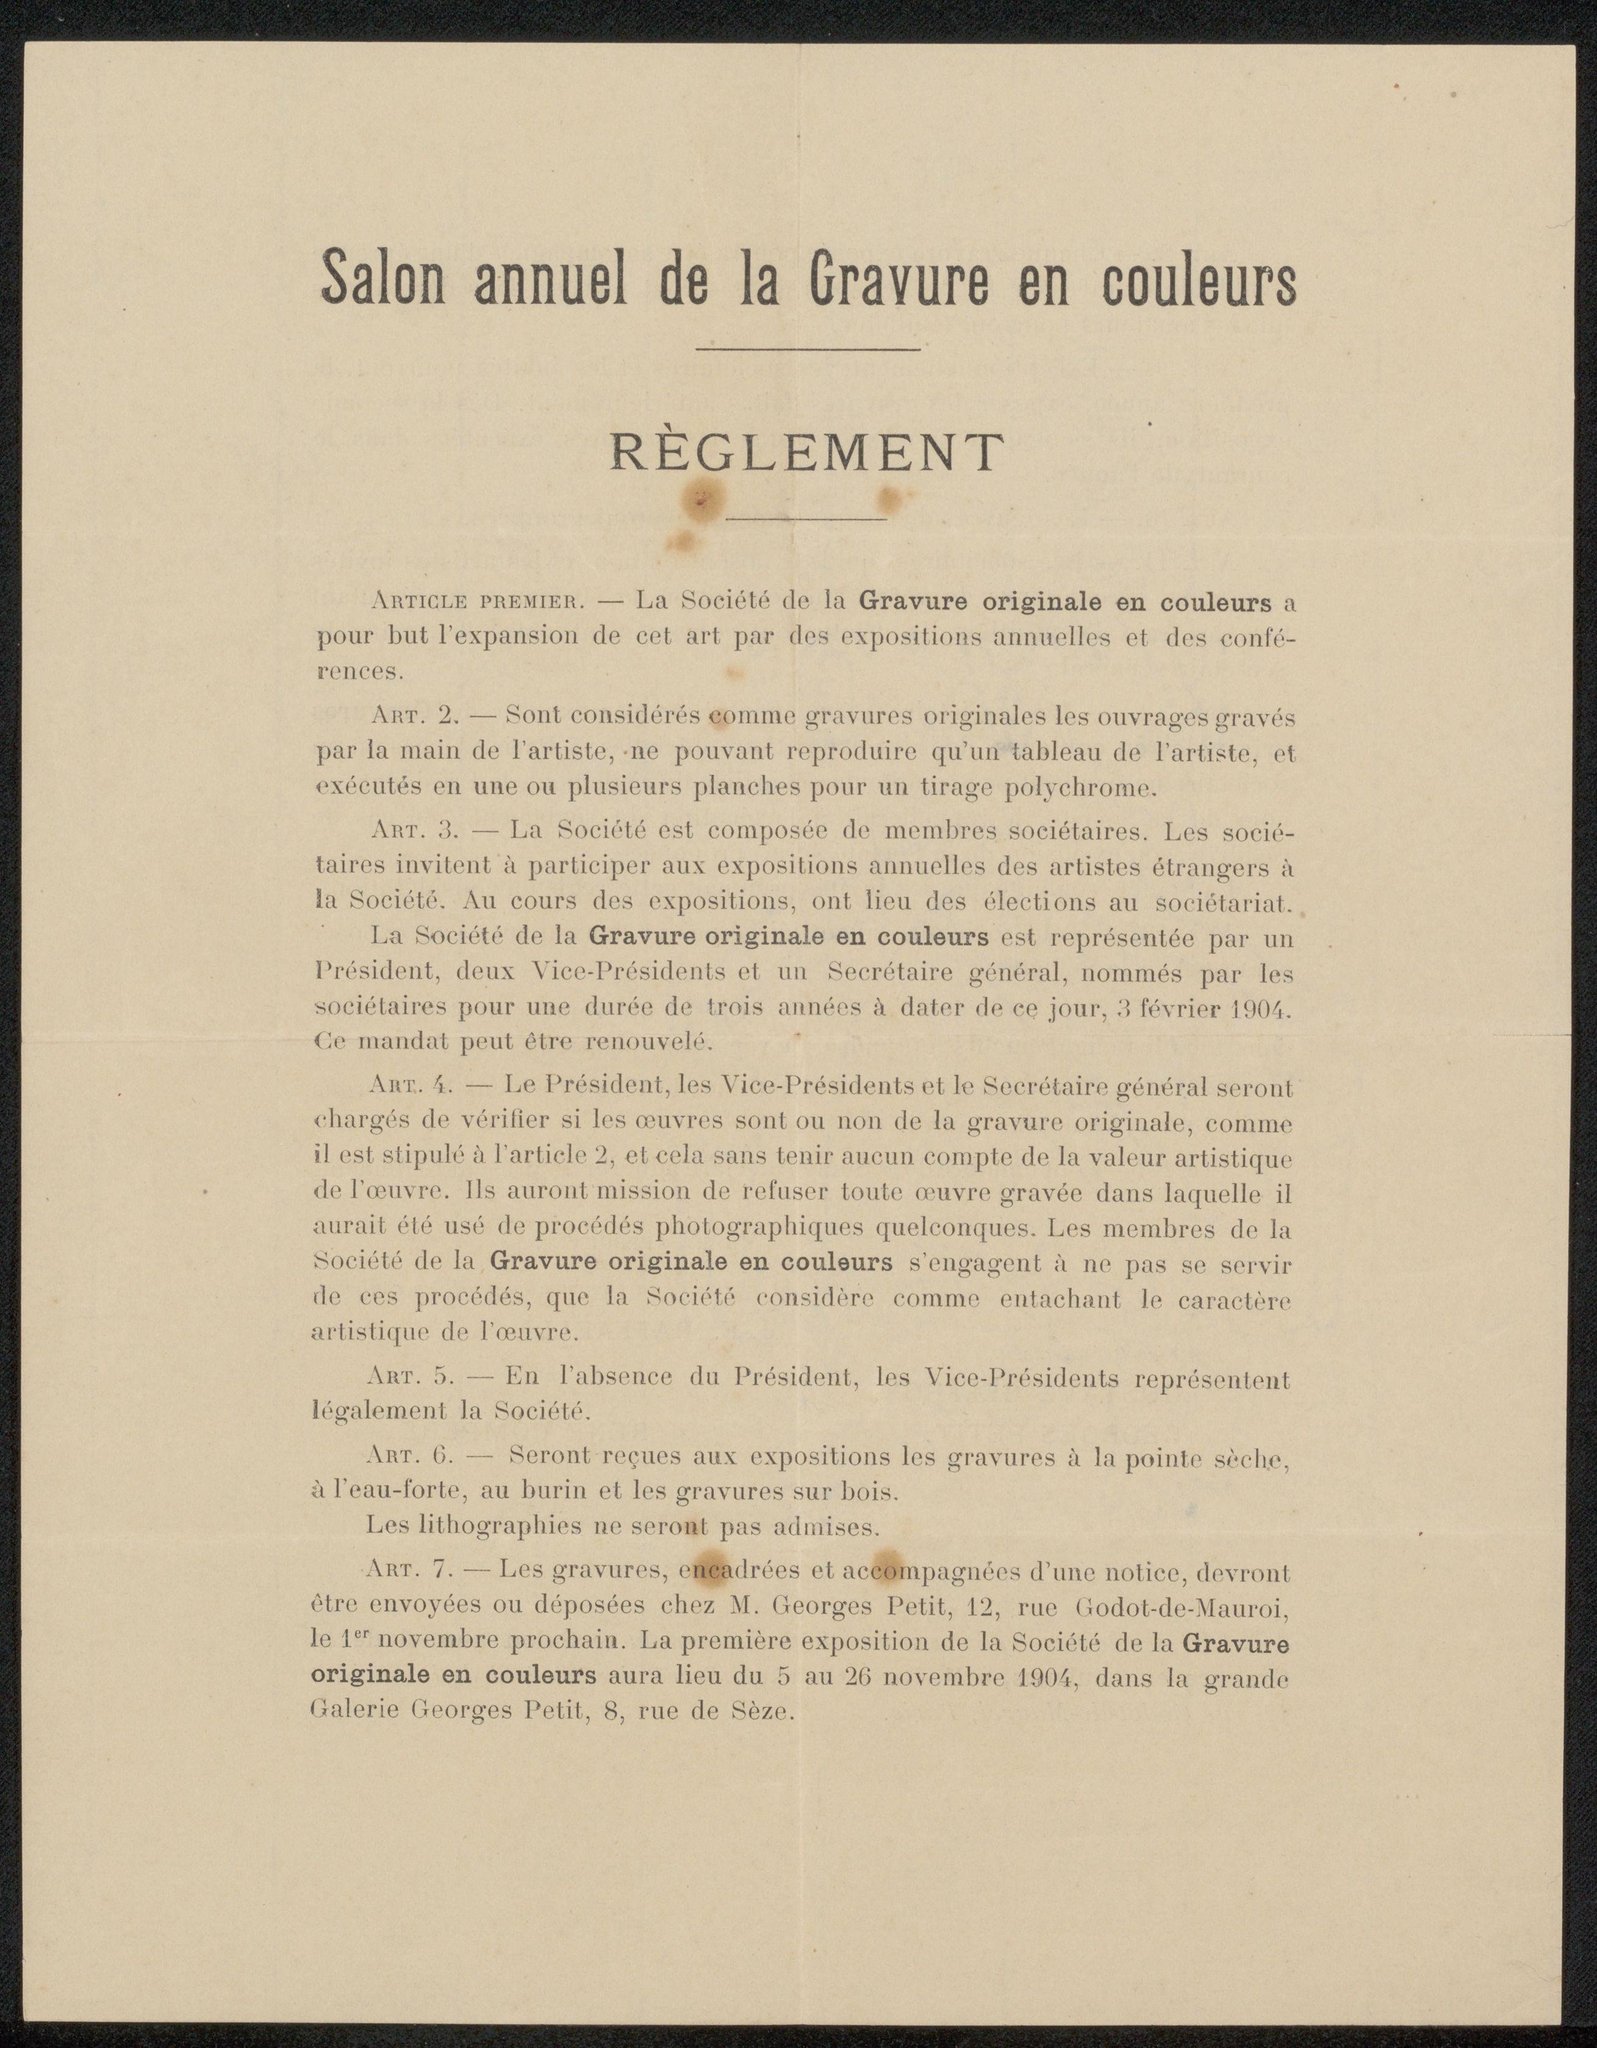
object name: document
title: Reglement uit archief Philip Zilcken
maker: rené compère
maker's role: schrijver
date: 1904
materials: paper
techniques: printing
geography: paris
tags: print maker, jean françois raffaëlli, draughtsman, designer, gustave geffroy, paris, publisher, georges petit, the hague, philip zilcken, the graphic arts, exhibition ~ art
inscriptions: collector's mark: ‘RPK’